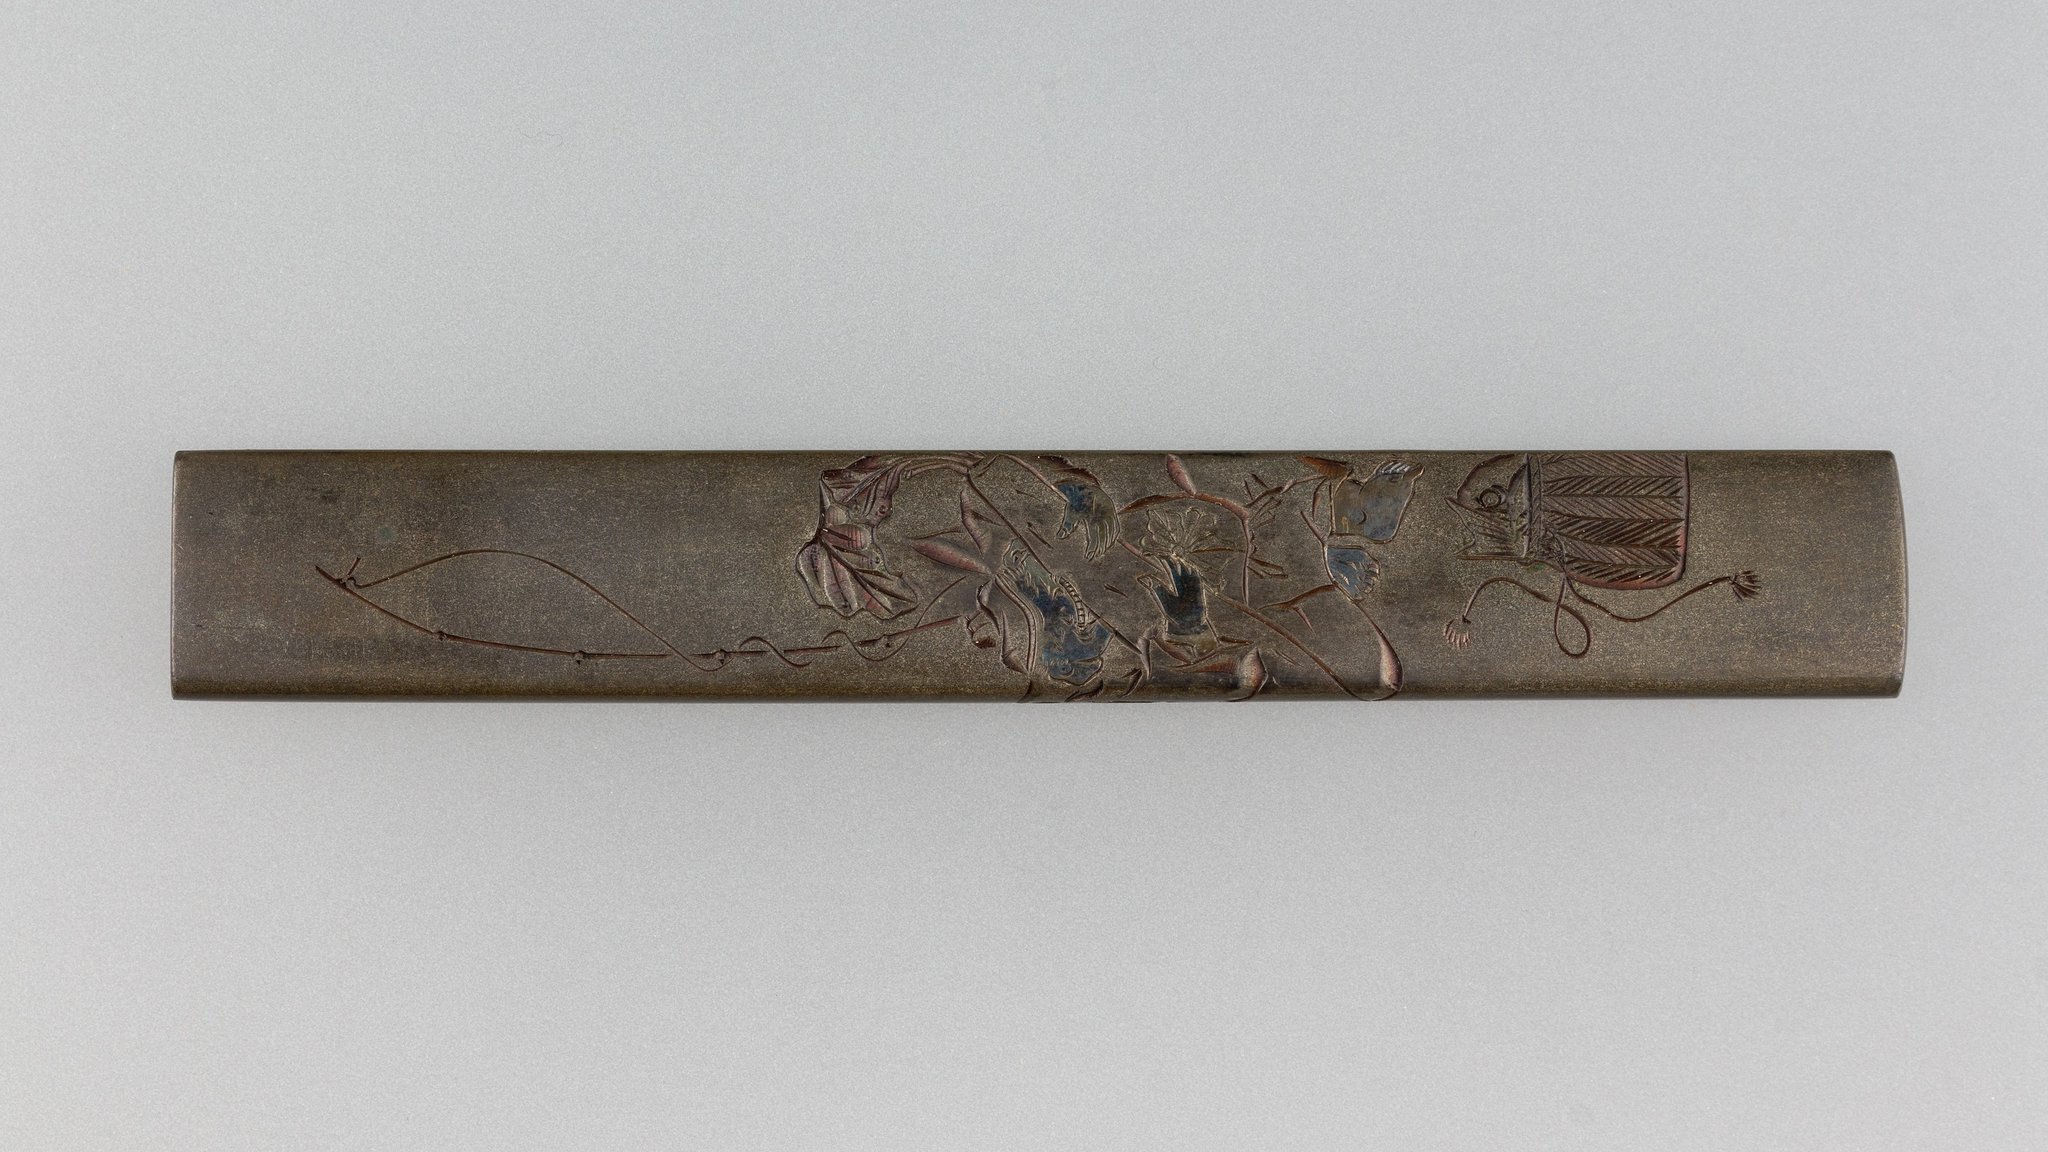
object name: knife handle kozuka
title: Knife Handle (Kozuka)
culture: japanese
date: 1800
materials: silver alloy, silver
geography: japan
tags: human figures